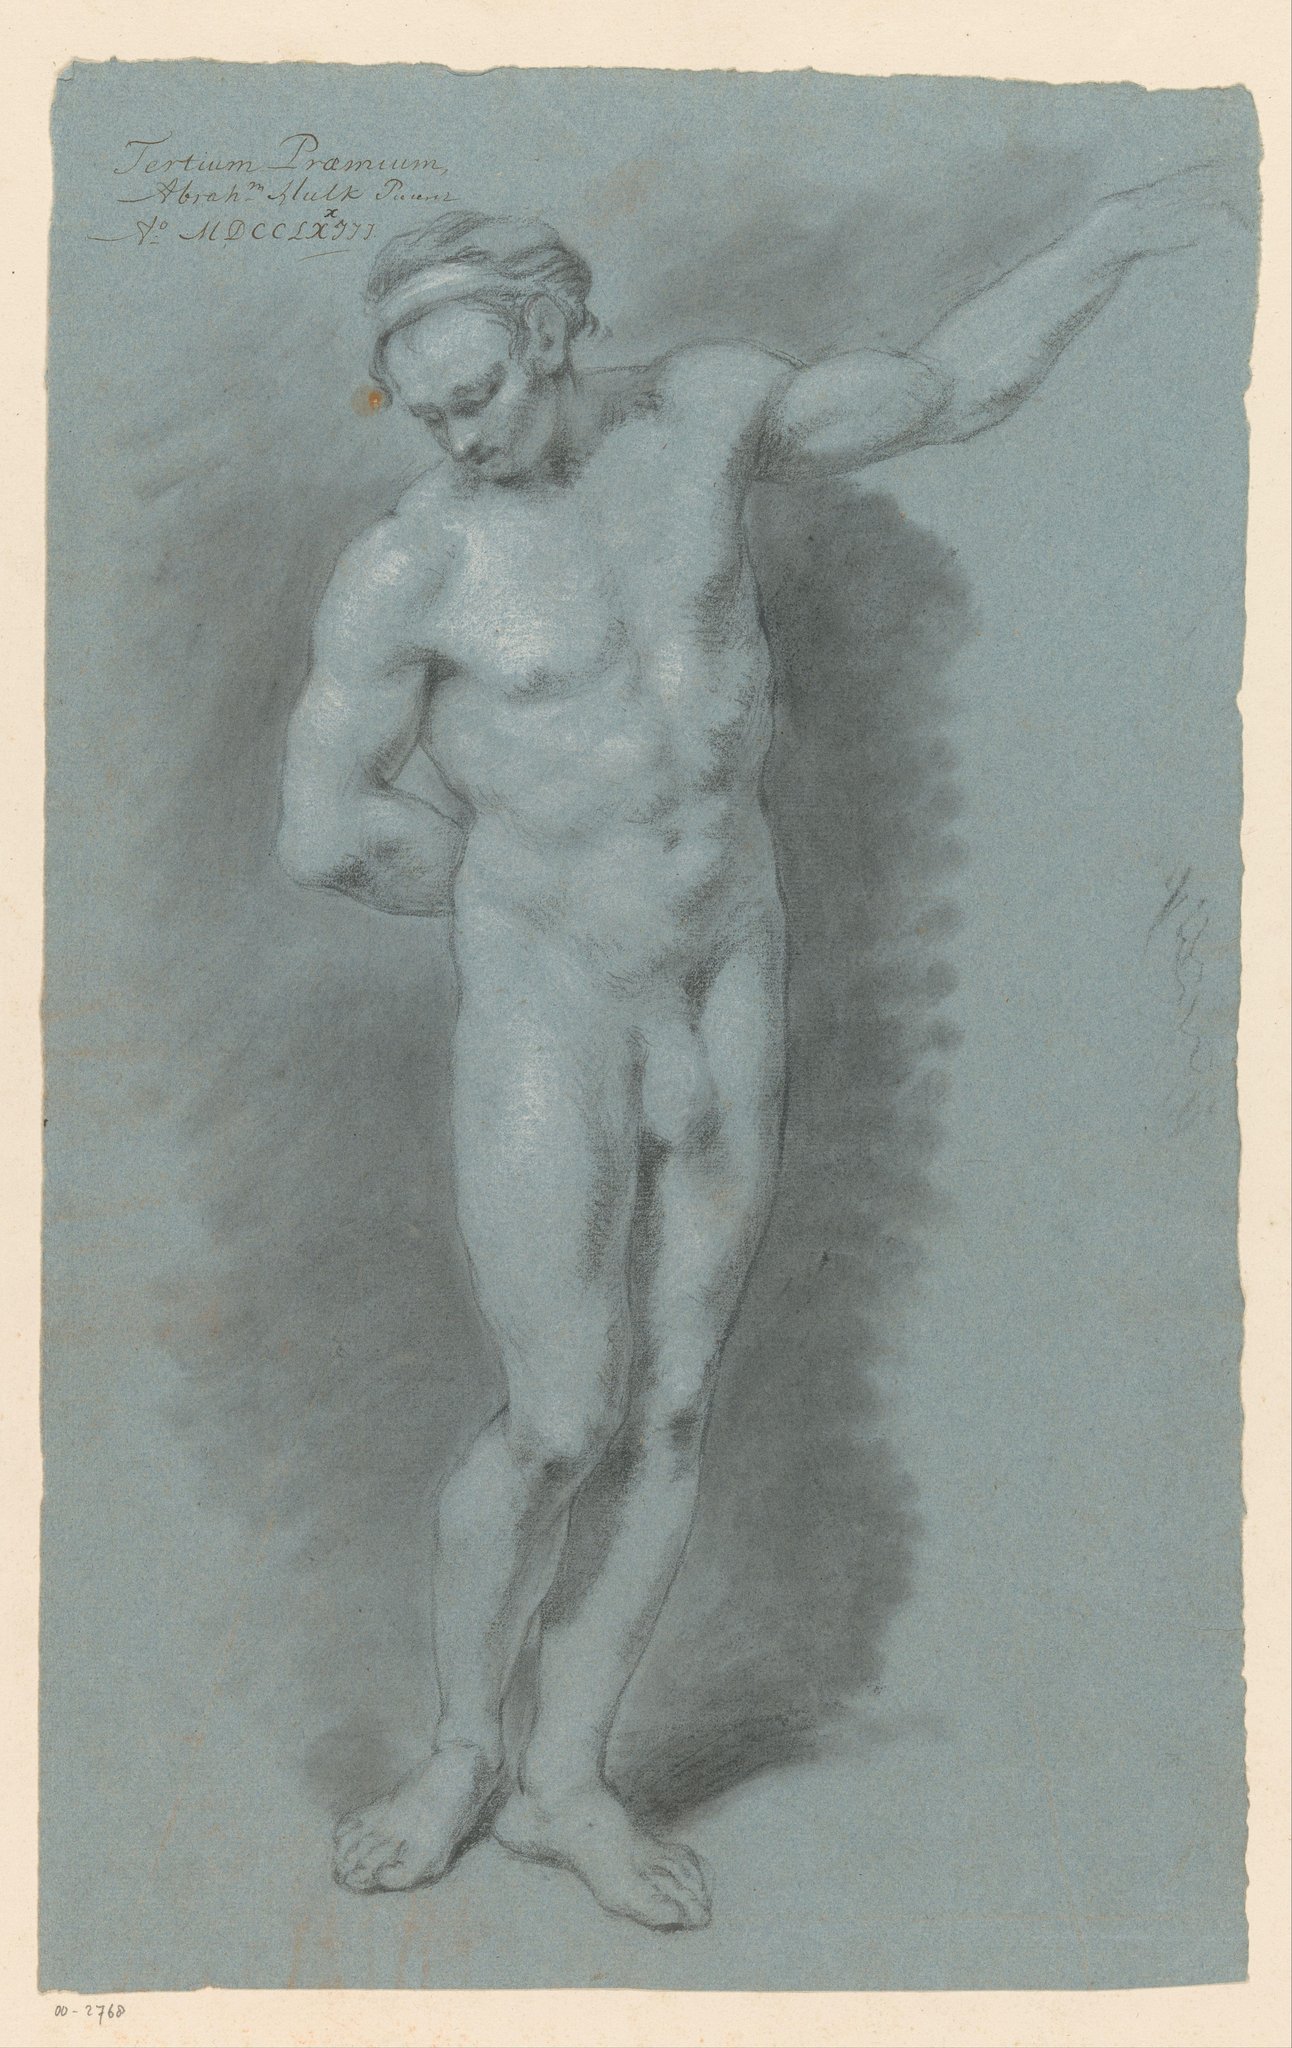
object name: drawing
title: Staand mannelijk naakt, van voren gezien (3e prijs 1773)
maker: abraham pietersz. hulk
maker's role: draughtsman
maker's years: 1752-1809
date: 1773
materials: chalk, paper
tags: standing figure (+ nude human being)